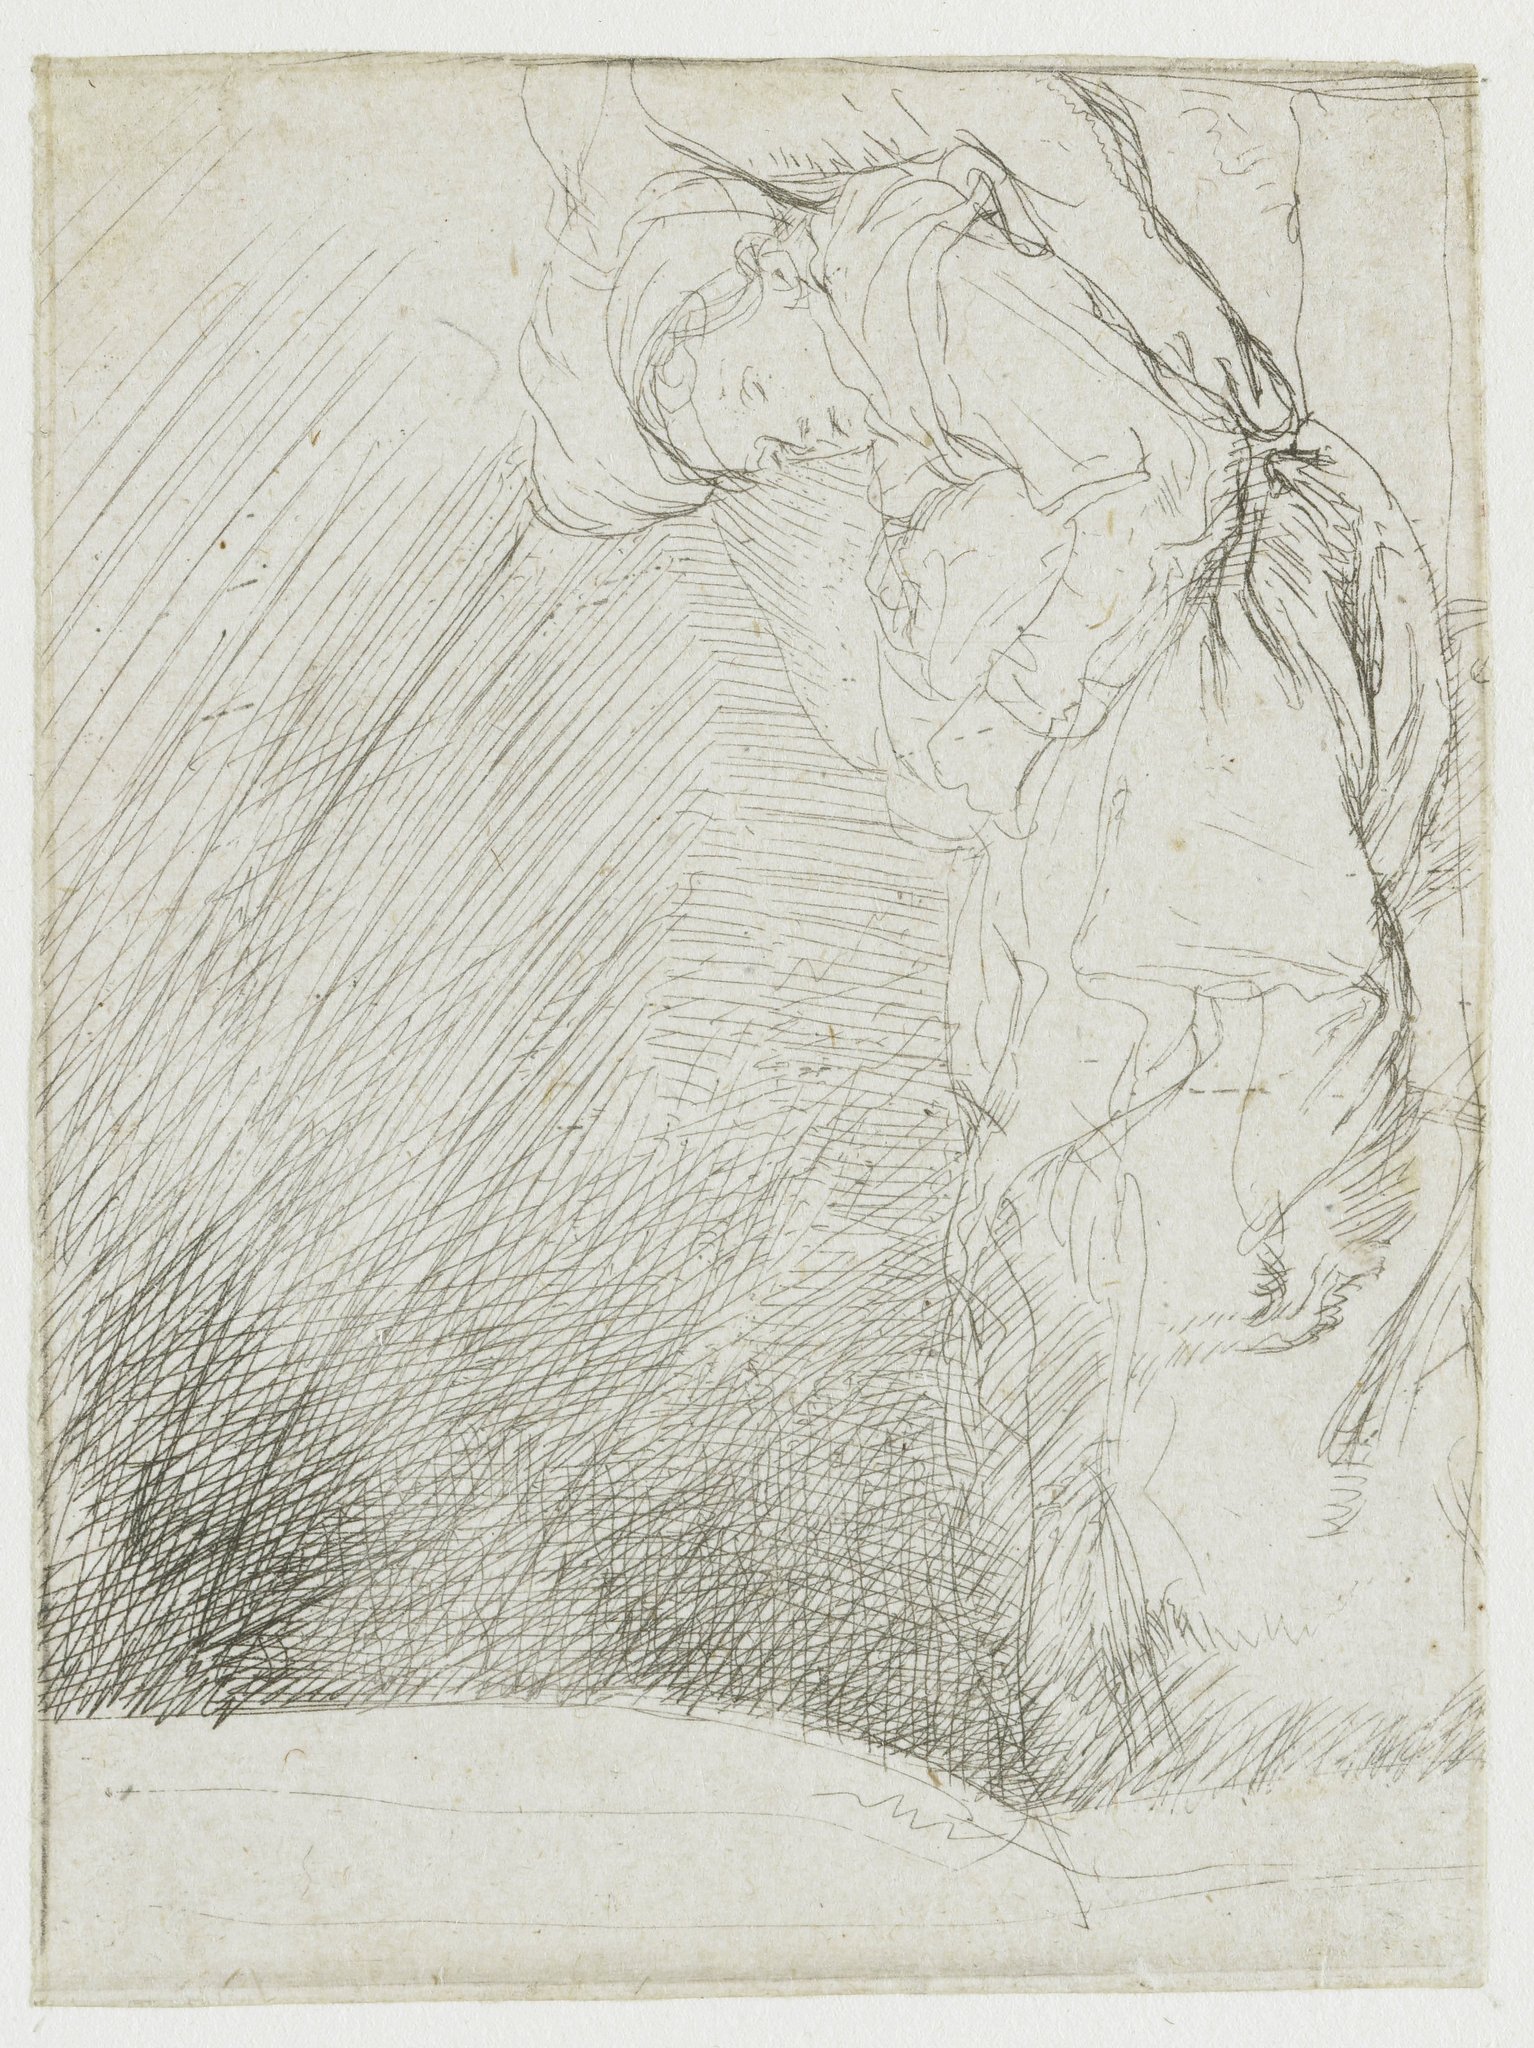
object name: fragment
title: Sheet of studies, with a woman lying ill in bed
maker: rembrandt van rijn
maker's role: draughtsman, painter, print maker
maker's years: 1606-1669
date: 1639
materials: ink, paper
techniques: etching, pen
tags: sick-bed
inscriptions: collector's mark: Lugt 240